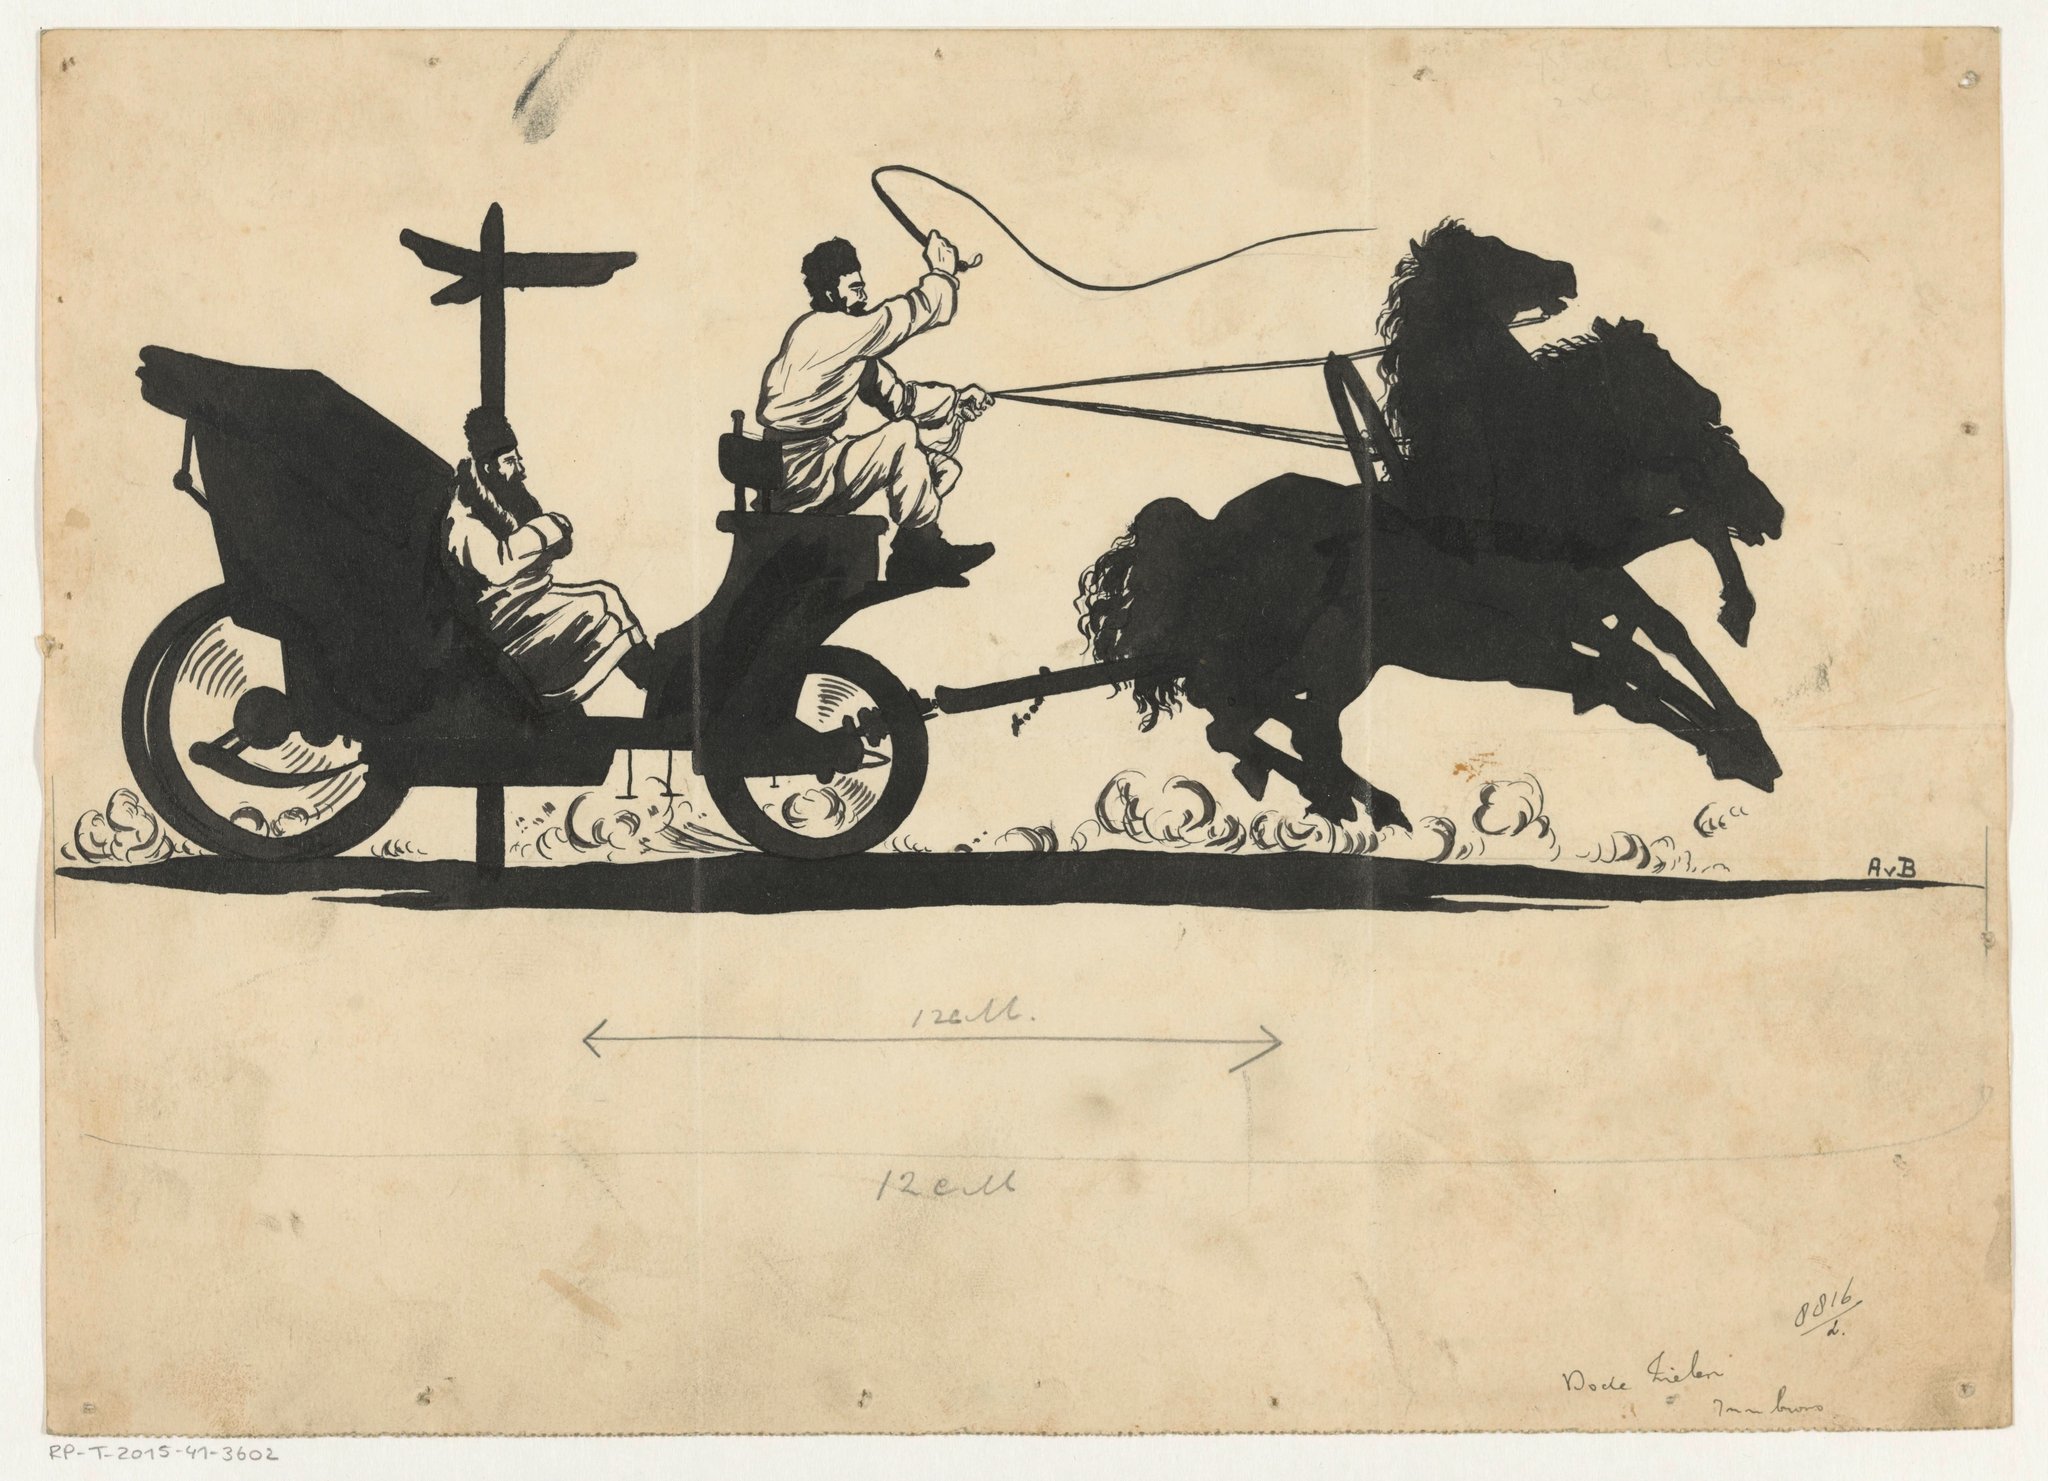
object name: boekillustratie ontwerp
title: Man in paardenkoets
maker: Anonymous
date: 1949-1950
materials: ink, paper, pencil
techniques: brush, pen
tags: signpost, animal traction, animal-drawn vehicle (carriage etc.)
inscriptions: collector's mark: Lugt 2228a, signature: ‘AvB’, :, annotation: ‘Dode Zielen/ [...]’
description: Een man met een bontmuts, lange baard en mantel zit met de armen over elkaar in een koets die wordt voortgetrokken door twee paarden en bestuurd wordt door een koetsier die met een zweep slaat. De koets passeert een wegwijzer.